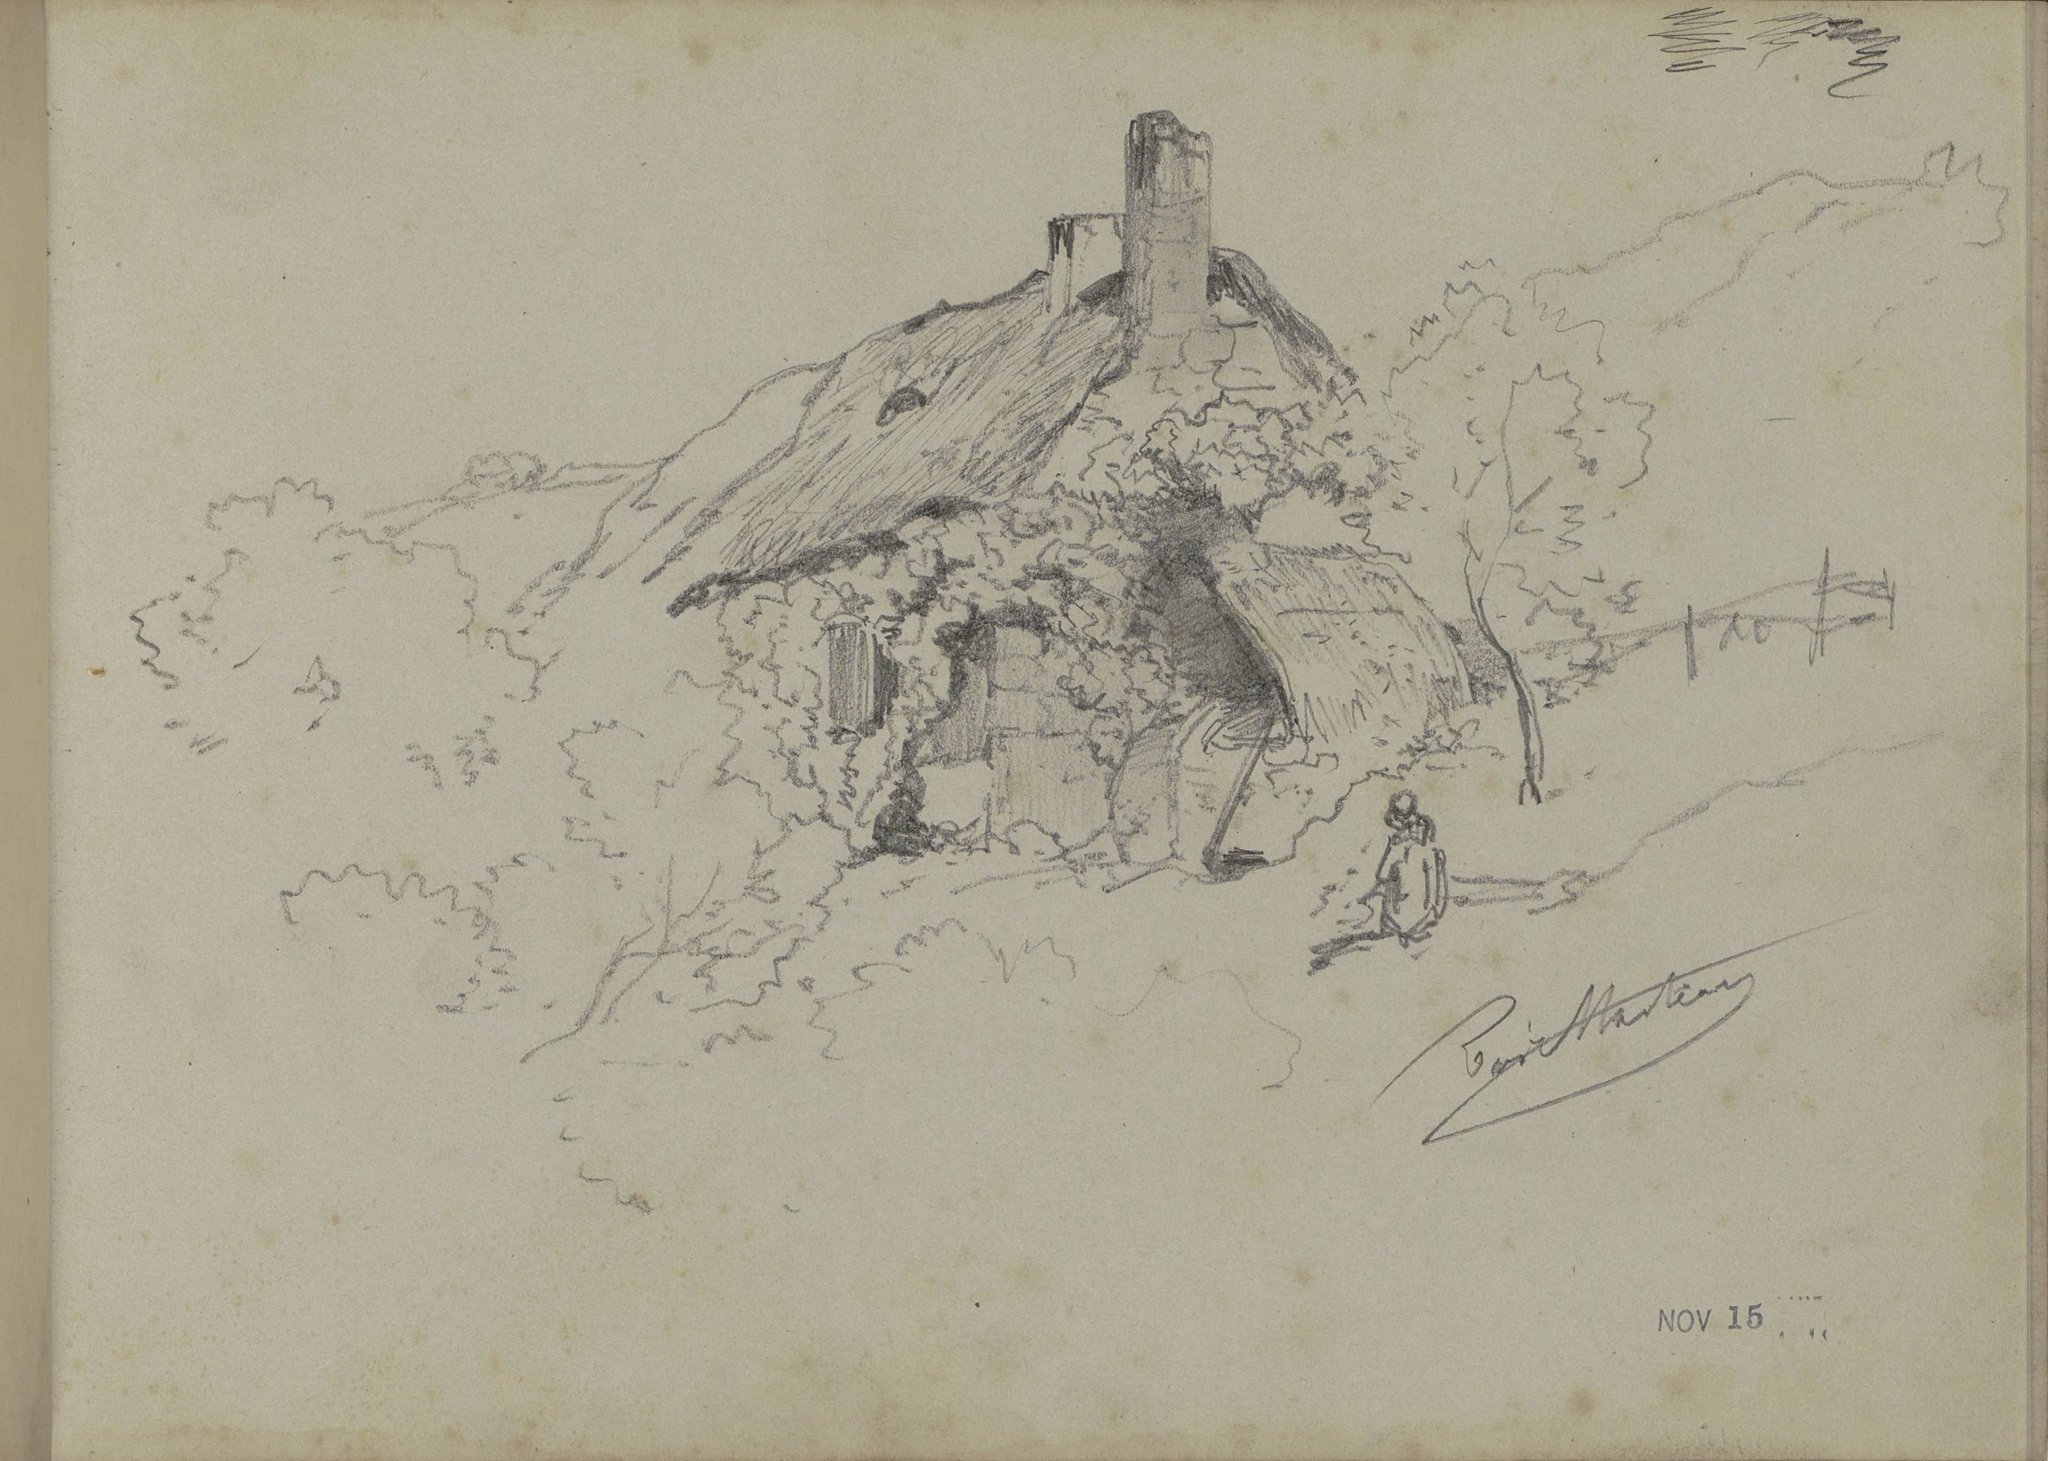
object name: sketchbook leaf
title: Boerderij met figuur te Bois Marteau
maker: willem roelofs (i)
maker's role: draughtsman, painter, print maker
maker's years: 1822-1897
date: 1846-1851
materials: paper, pencil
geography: marteau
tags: farm or solitary house in landscape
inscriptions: annotation: ‘Bois Marteau’, date: ‘NOV 15 , ,,’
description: Blad 9 recto uit een schetsboek met 25 bladen.